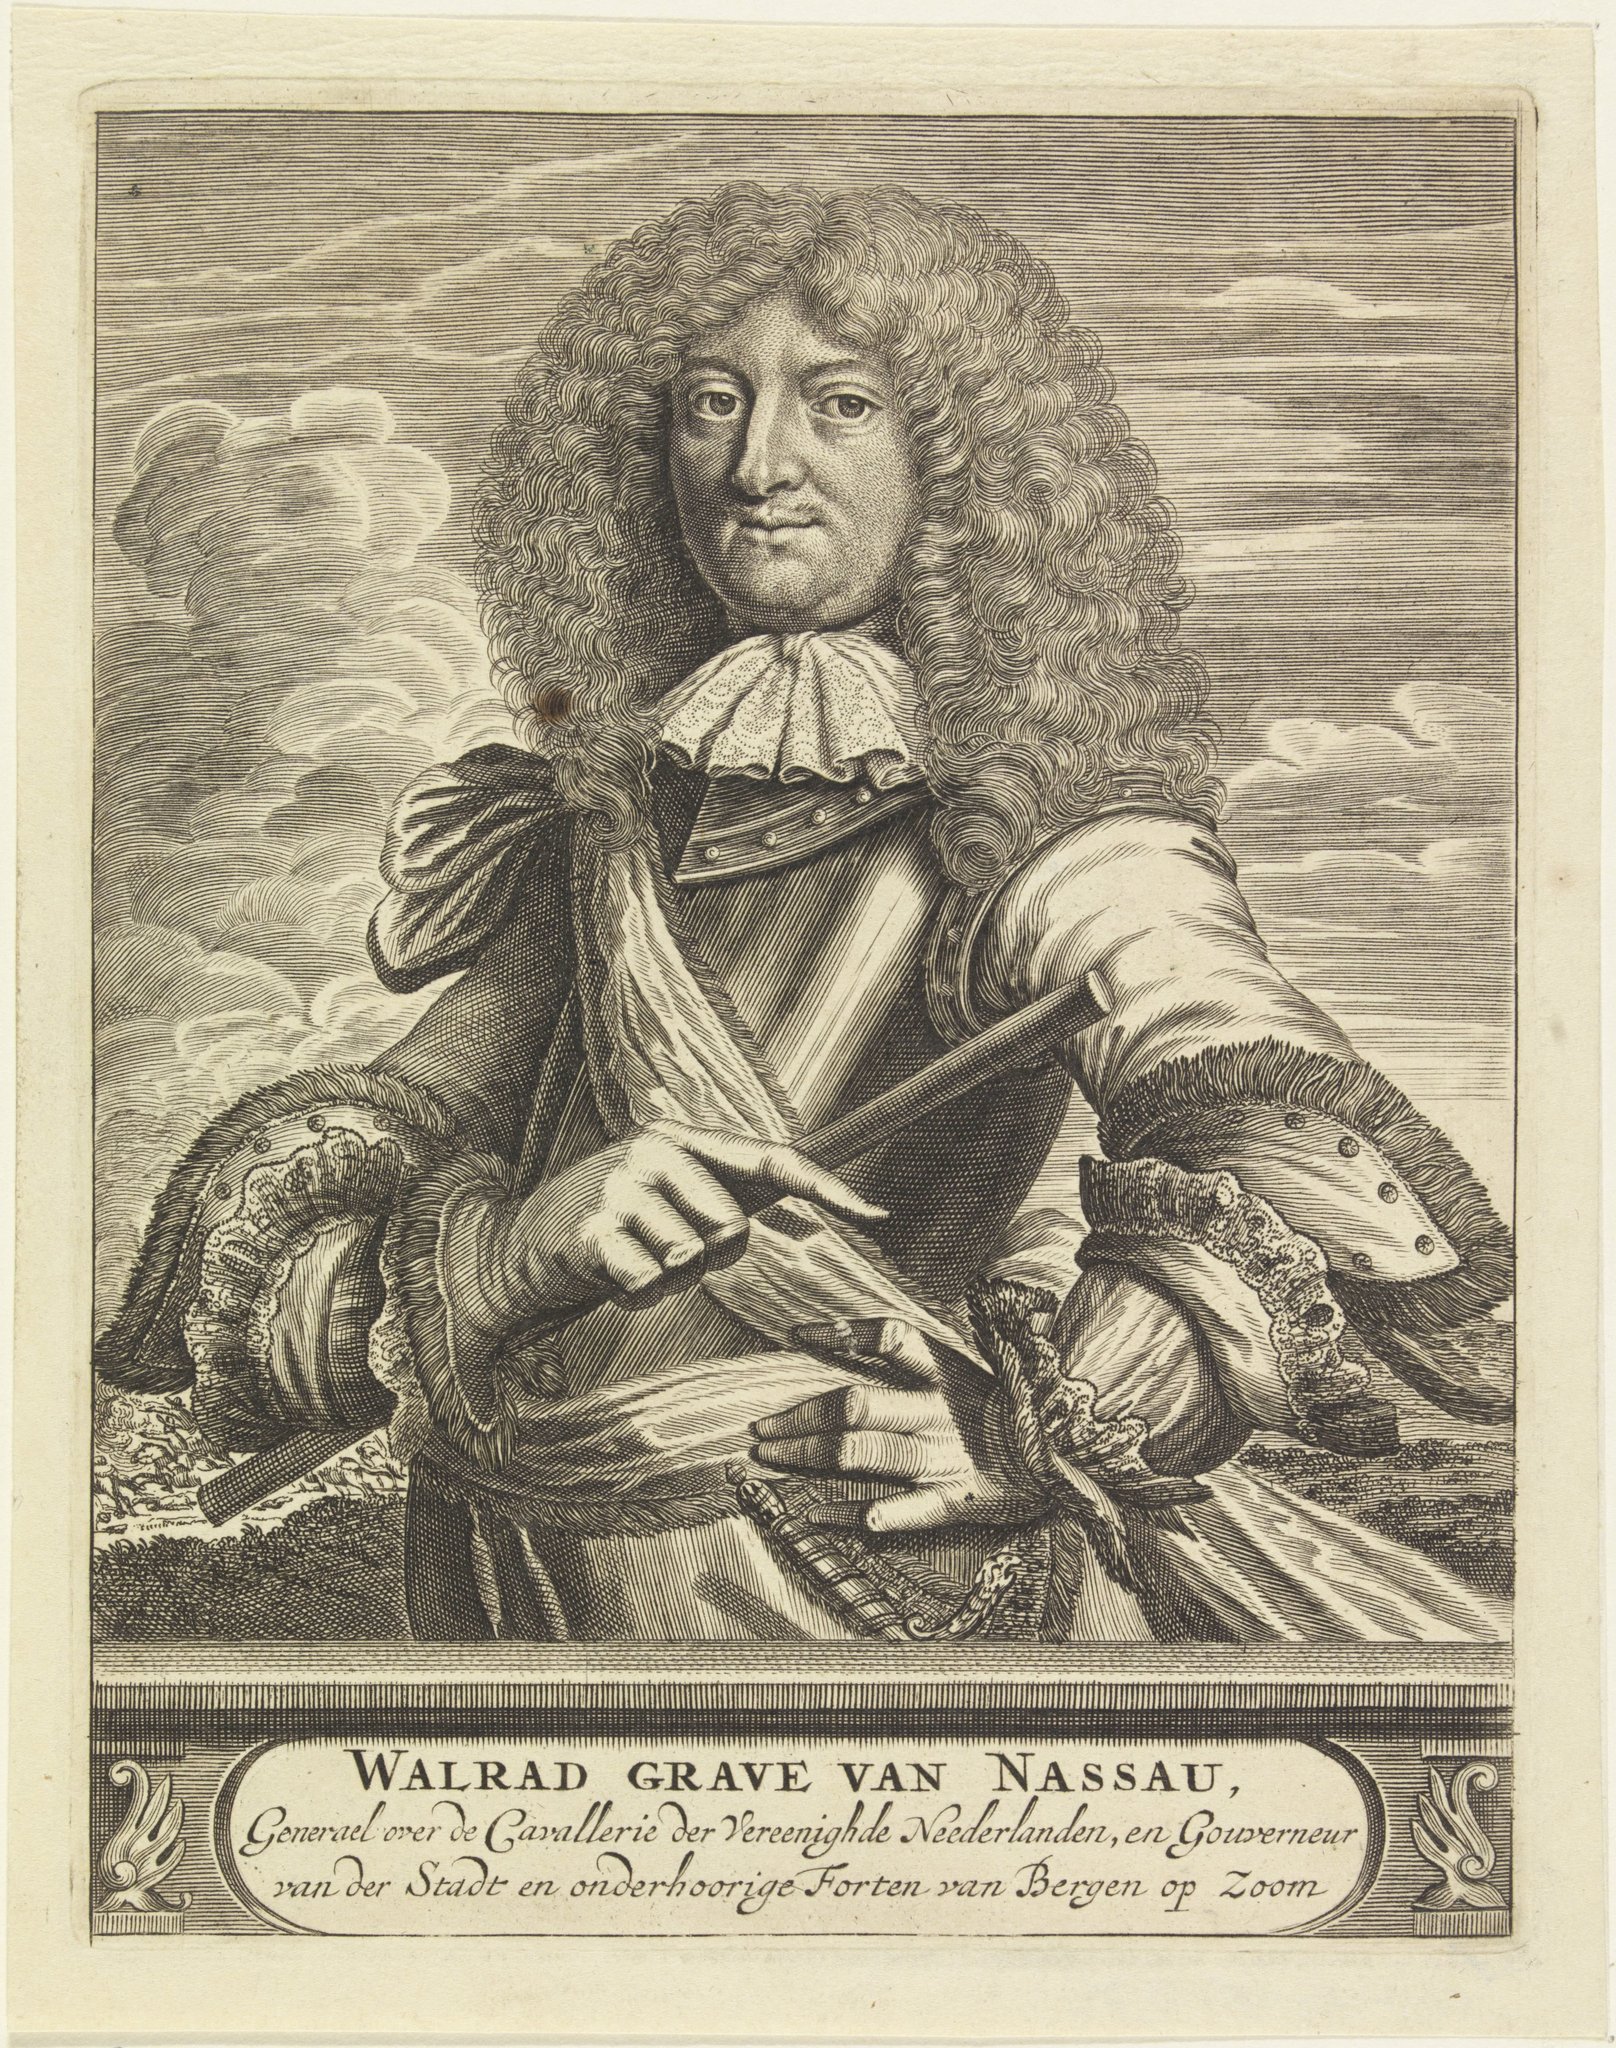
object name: print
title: Portret van Wolrat van Nassau-Usingen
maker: Anonymous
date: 1650-1749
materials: paper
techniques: engraving, etching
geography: low countries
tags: earl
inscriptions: collector's mark: Lugt 963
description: Portret van Wolrat. In zijn rechterhand een commandostaf. Op een voetstuk zijn naam en titels.